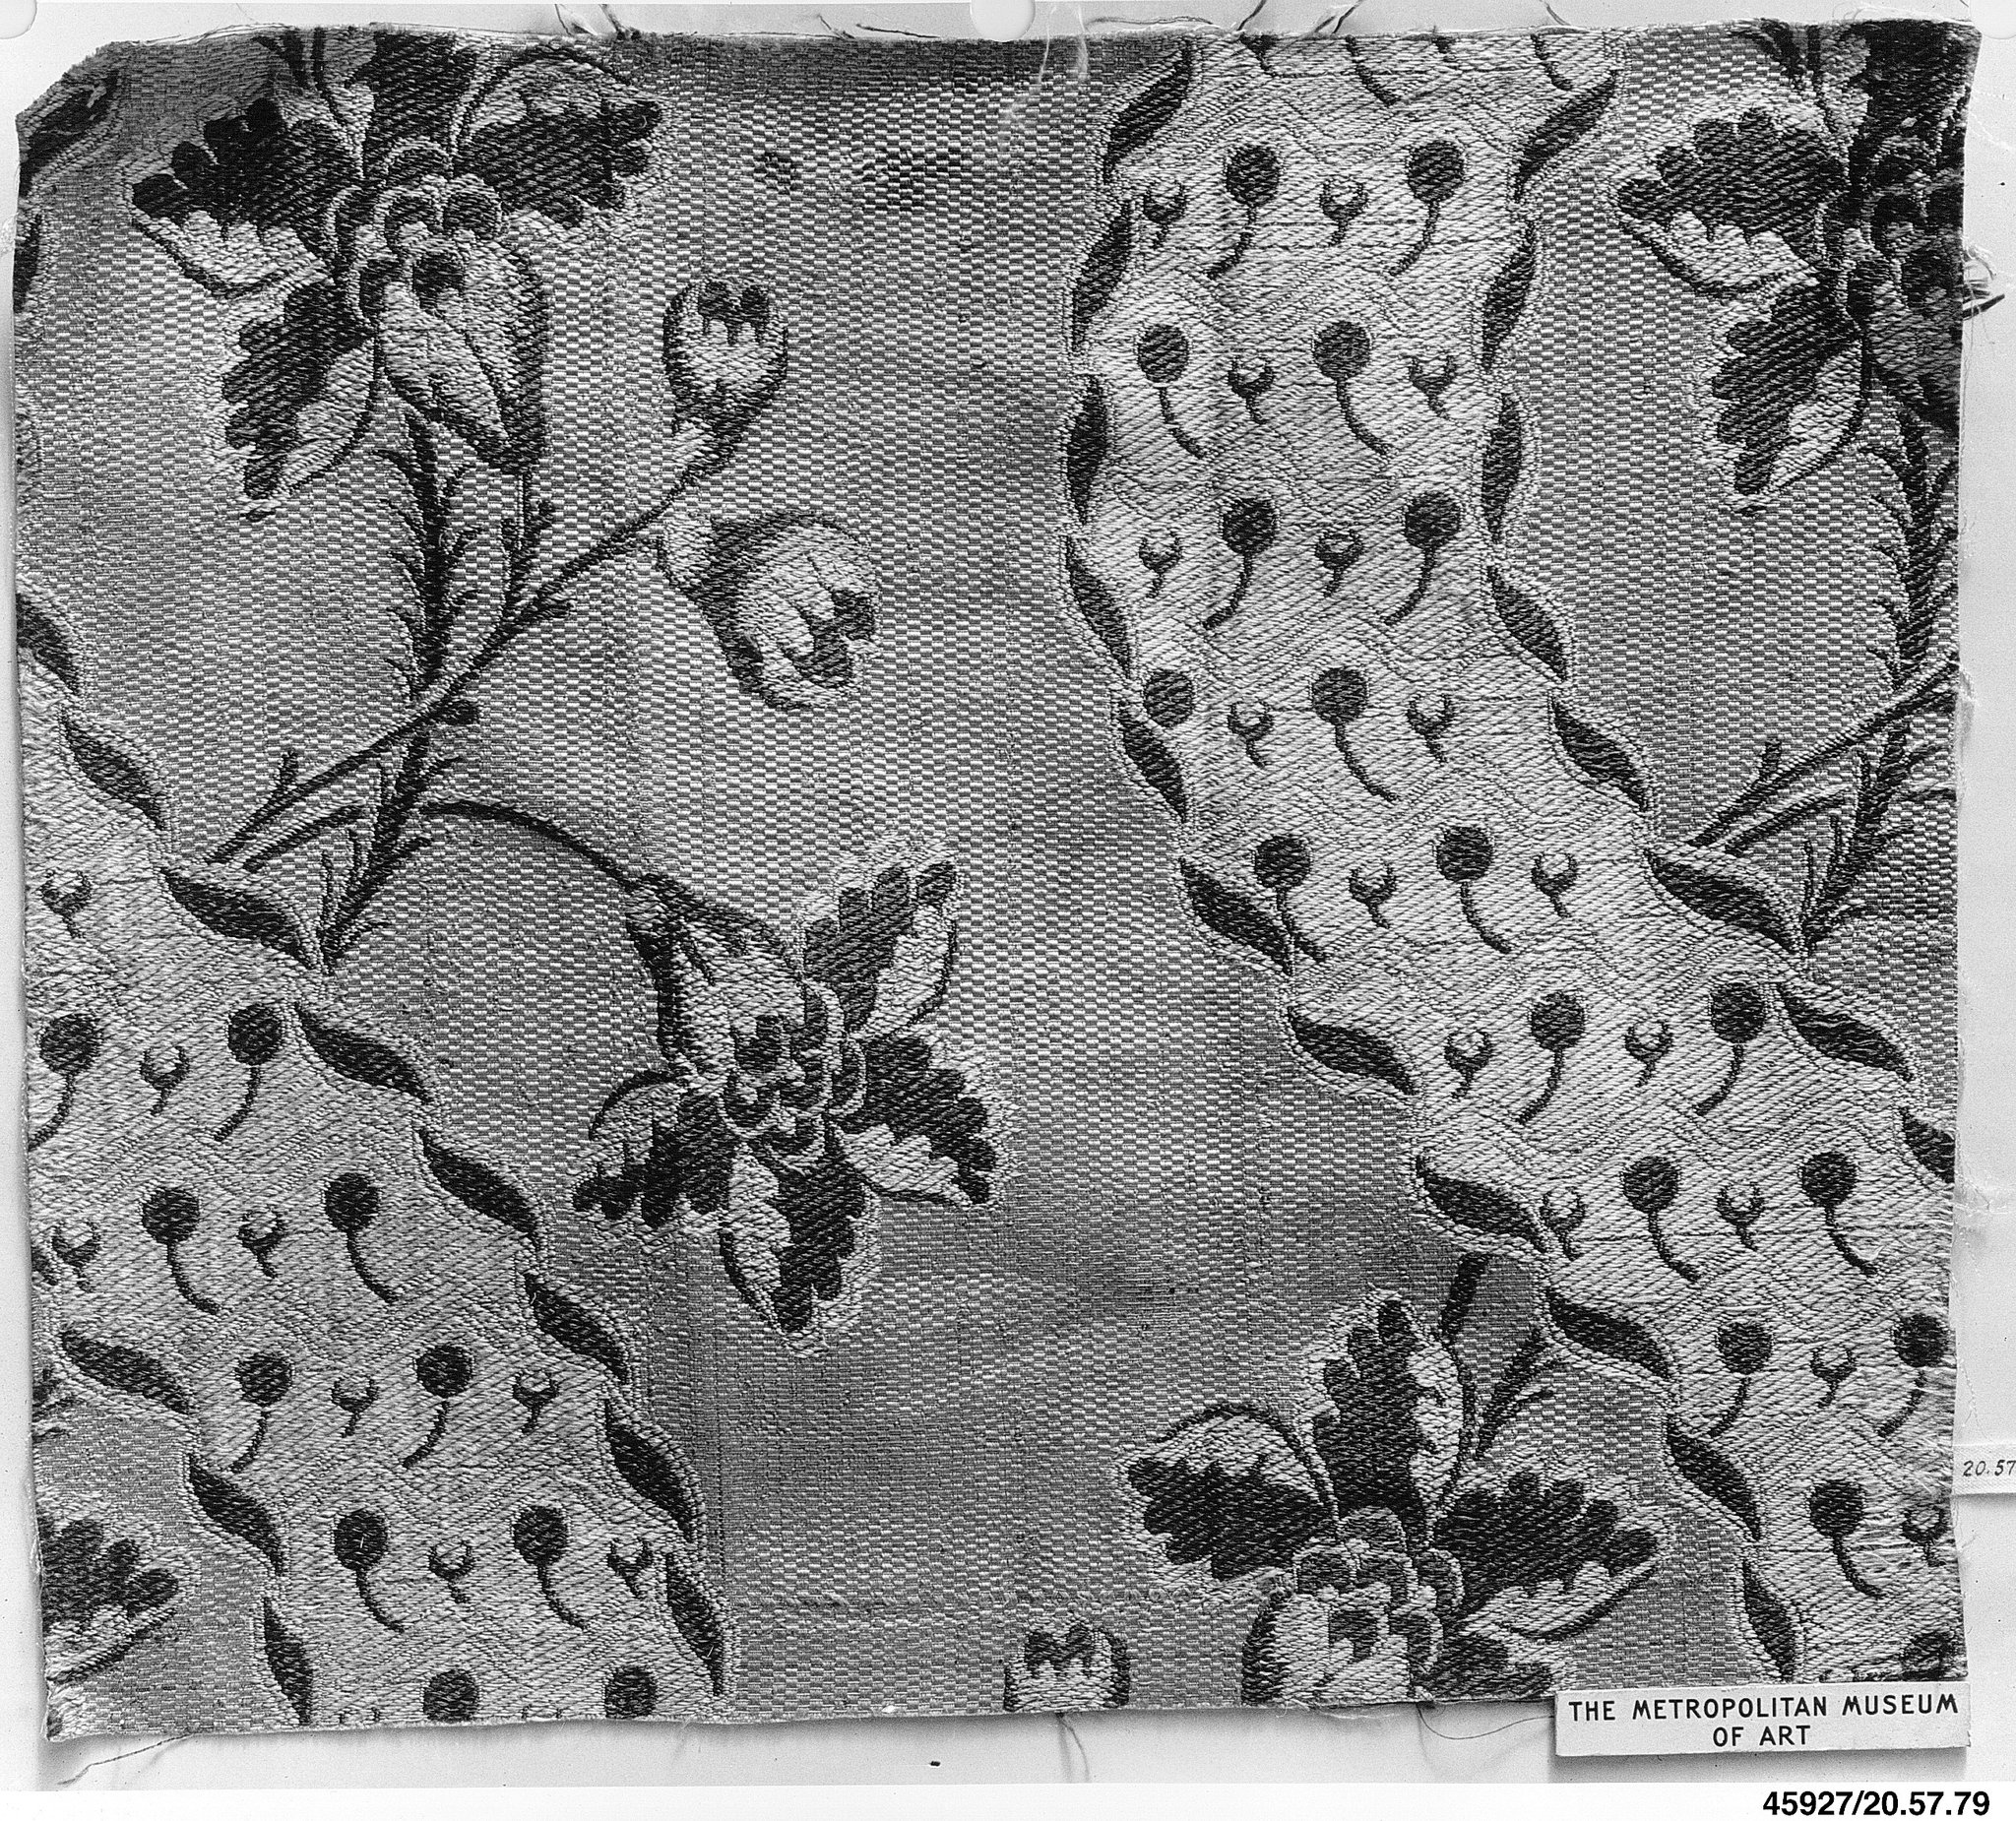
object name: piece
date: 1750-1760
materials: silk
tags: flowers,leaves